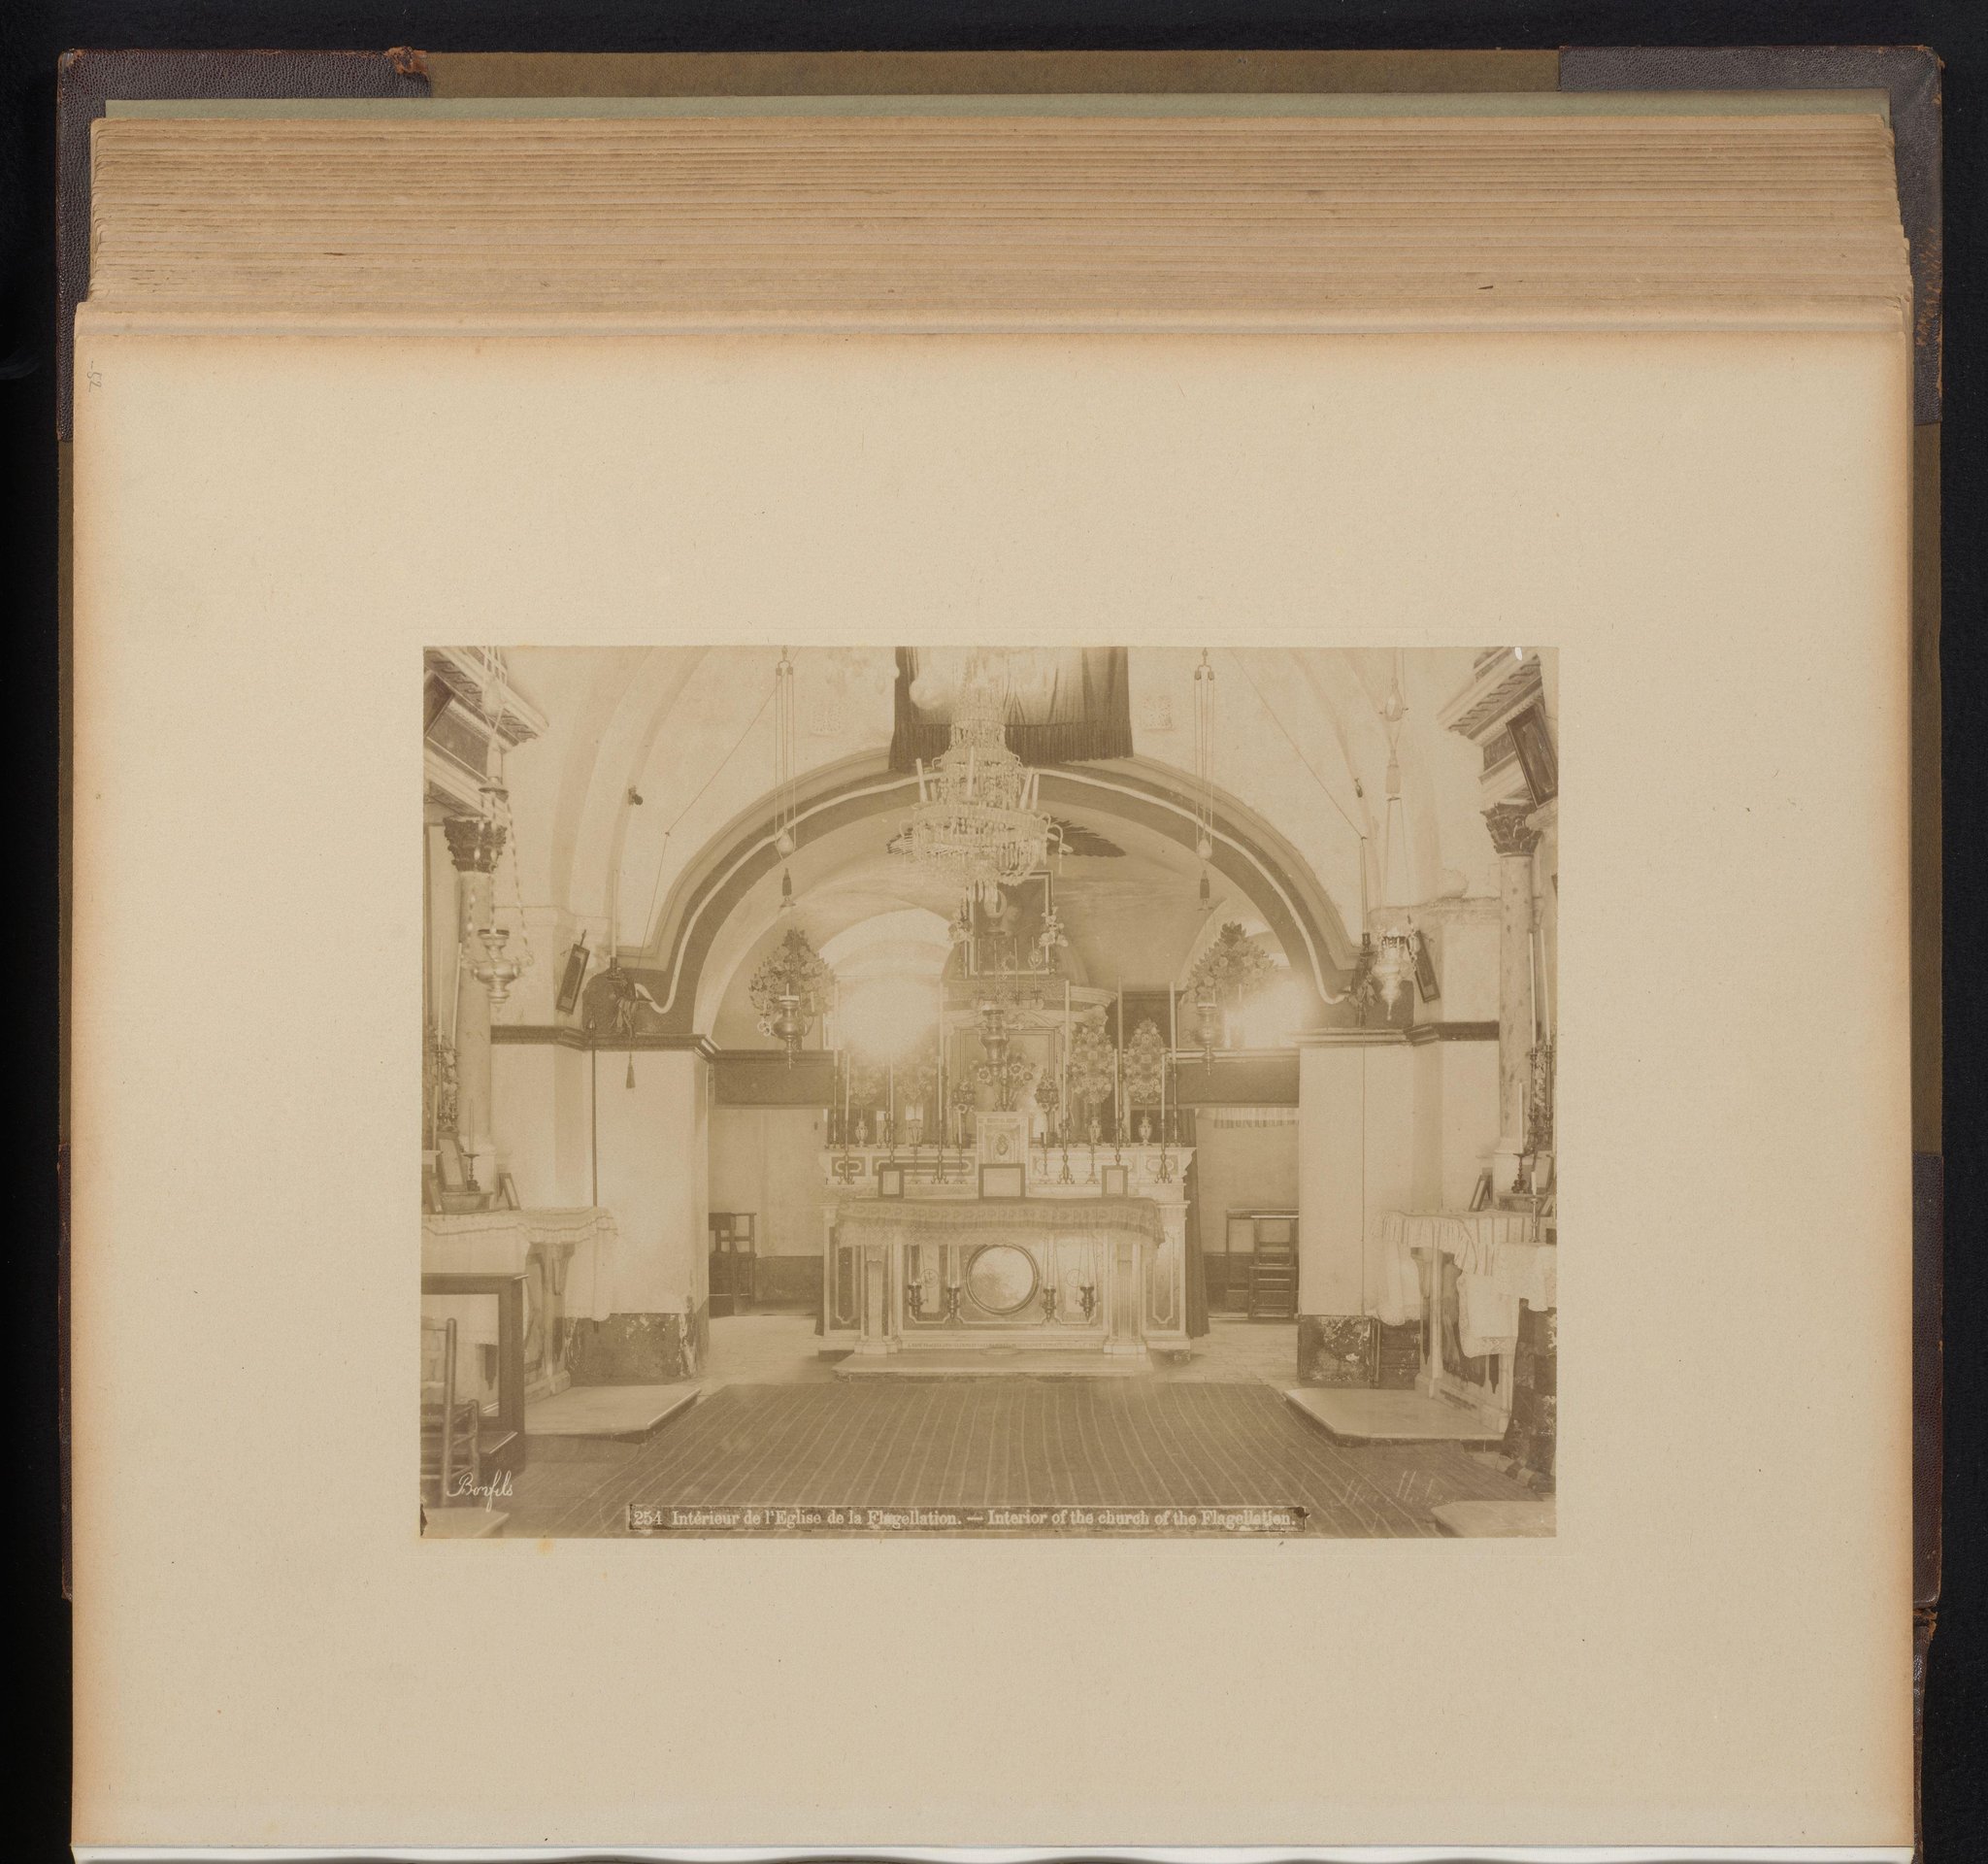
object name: photograph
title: Altaar in de kerk van de geseling in Jeruzalem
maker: félix bonfils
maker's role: fotograaf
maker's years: 1831-1885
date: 1867-1885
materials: paper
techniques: albumen print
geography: jerusalem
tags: interior of church, church of the flagellation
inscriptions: number: ‘254’